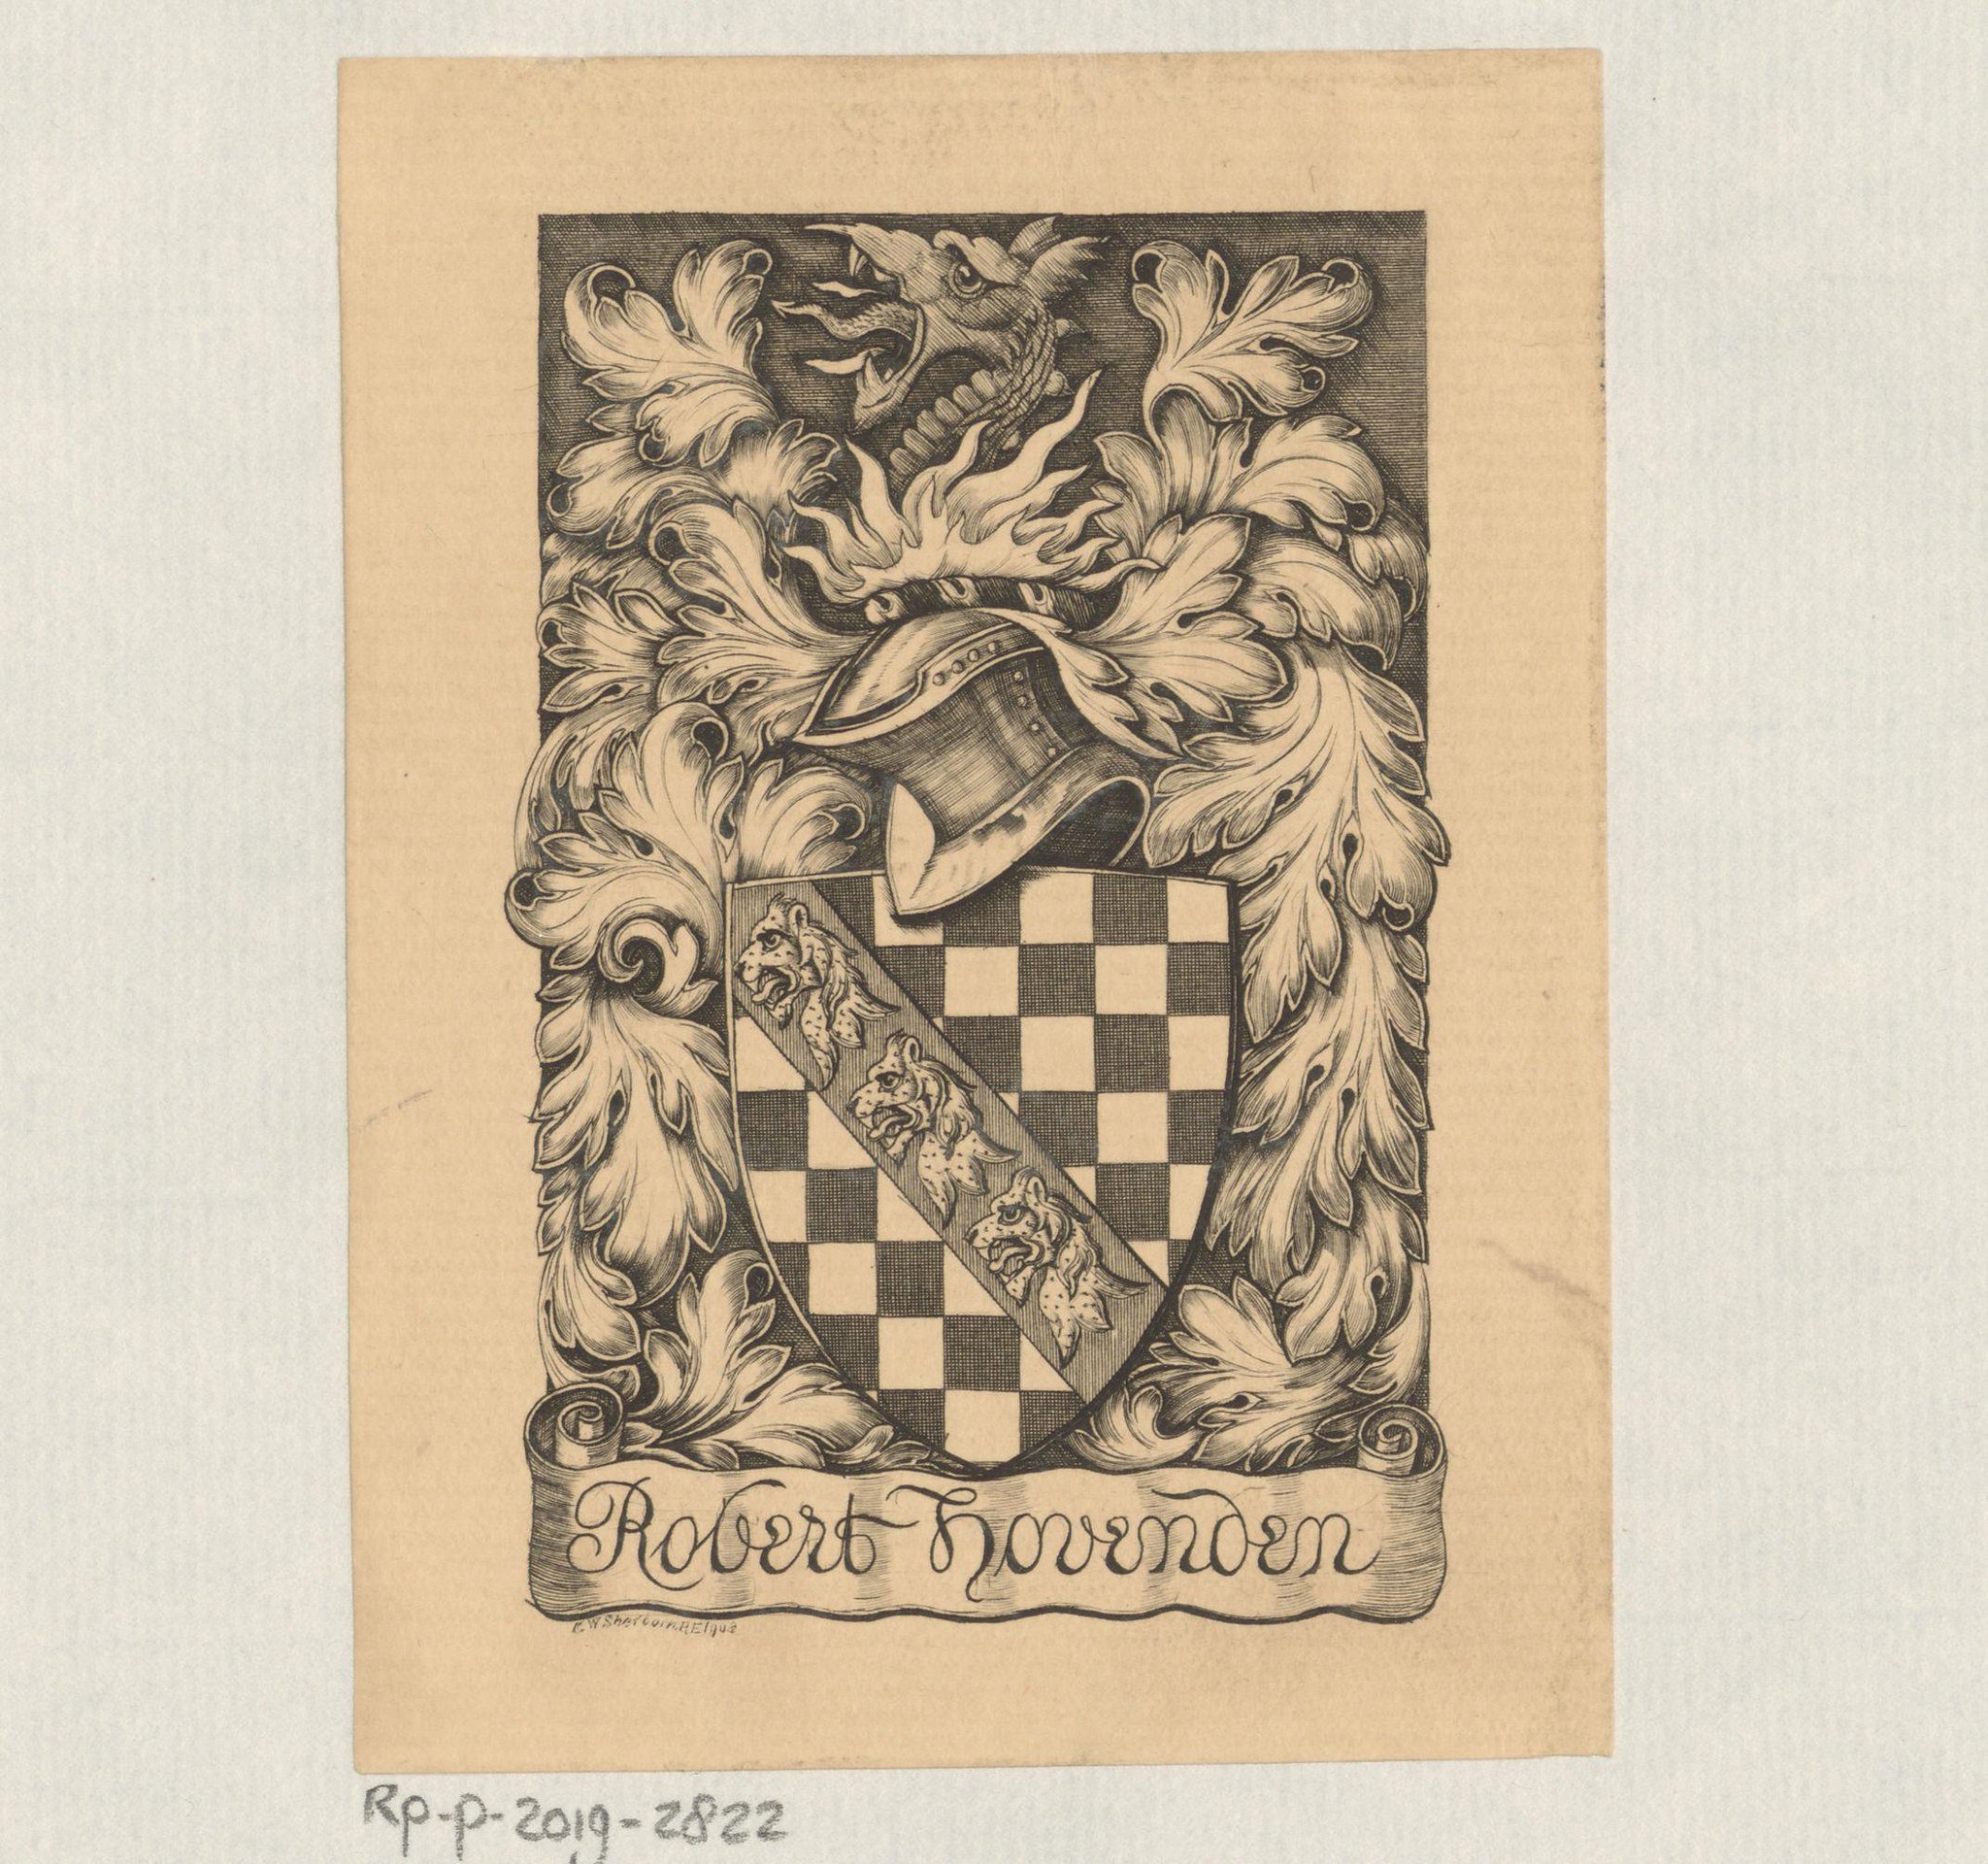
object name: bookplate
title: Ex libris van Robert Hovenden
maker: charles william sherborn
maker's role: print maker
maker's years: 1831-1912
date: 1908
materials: paper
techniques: engraving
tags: armorial bearing, heraldry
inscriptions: date